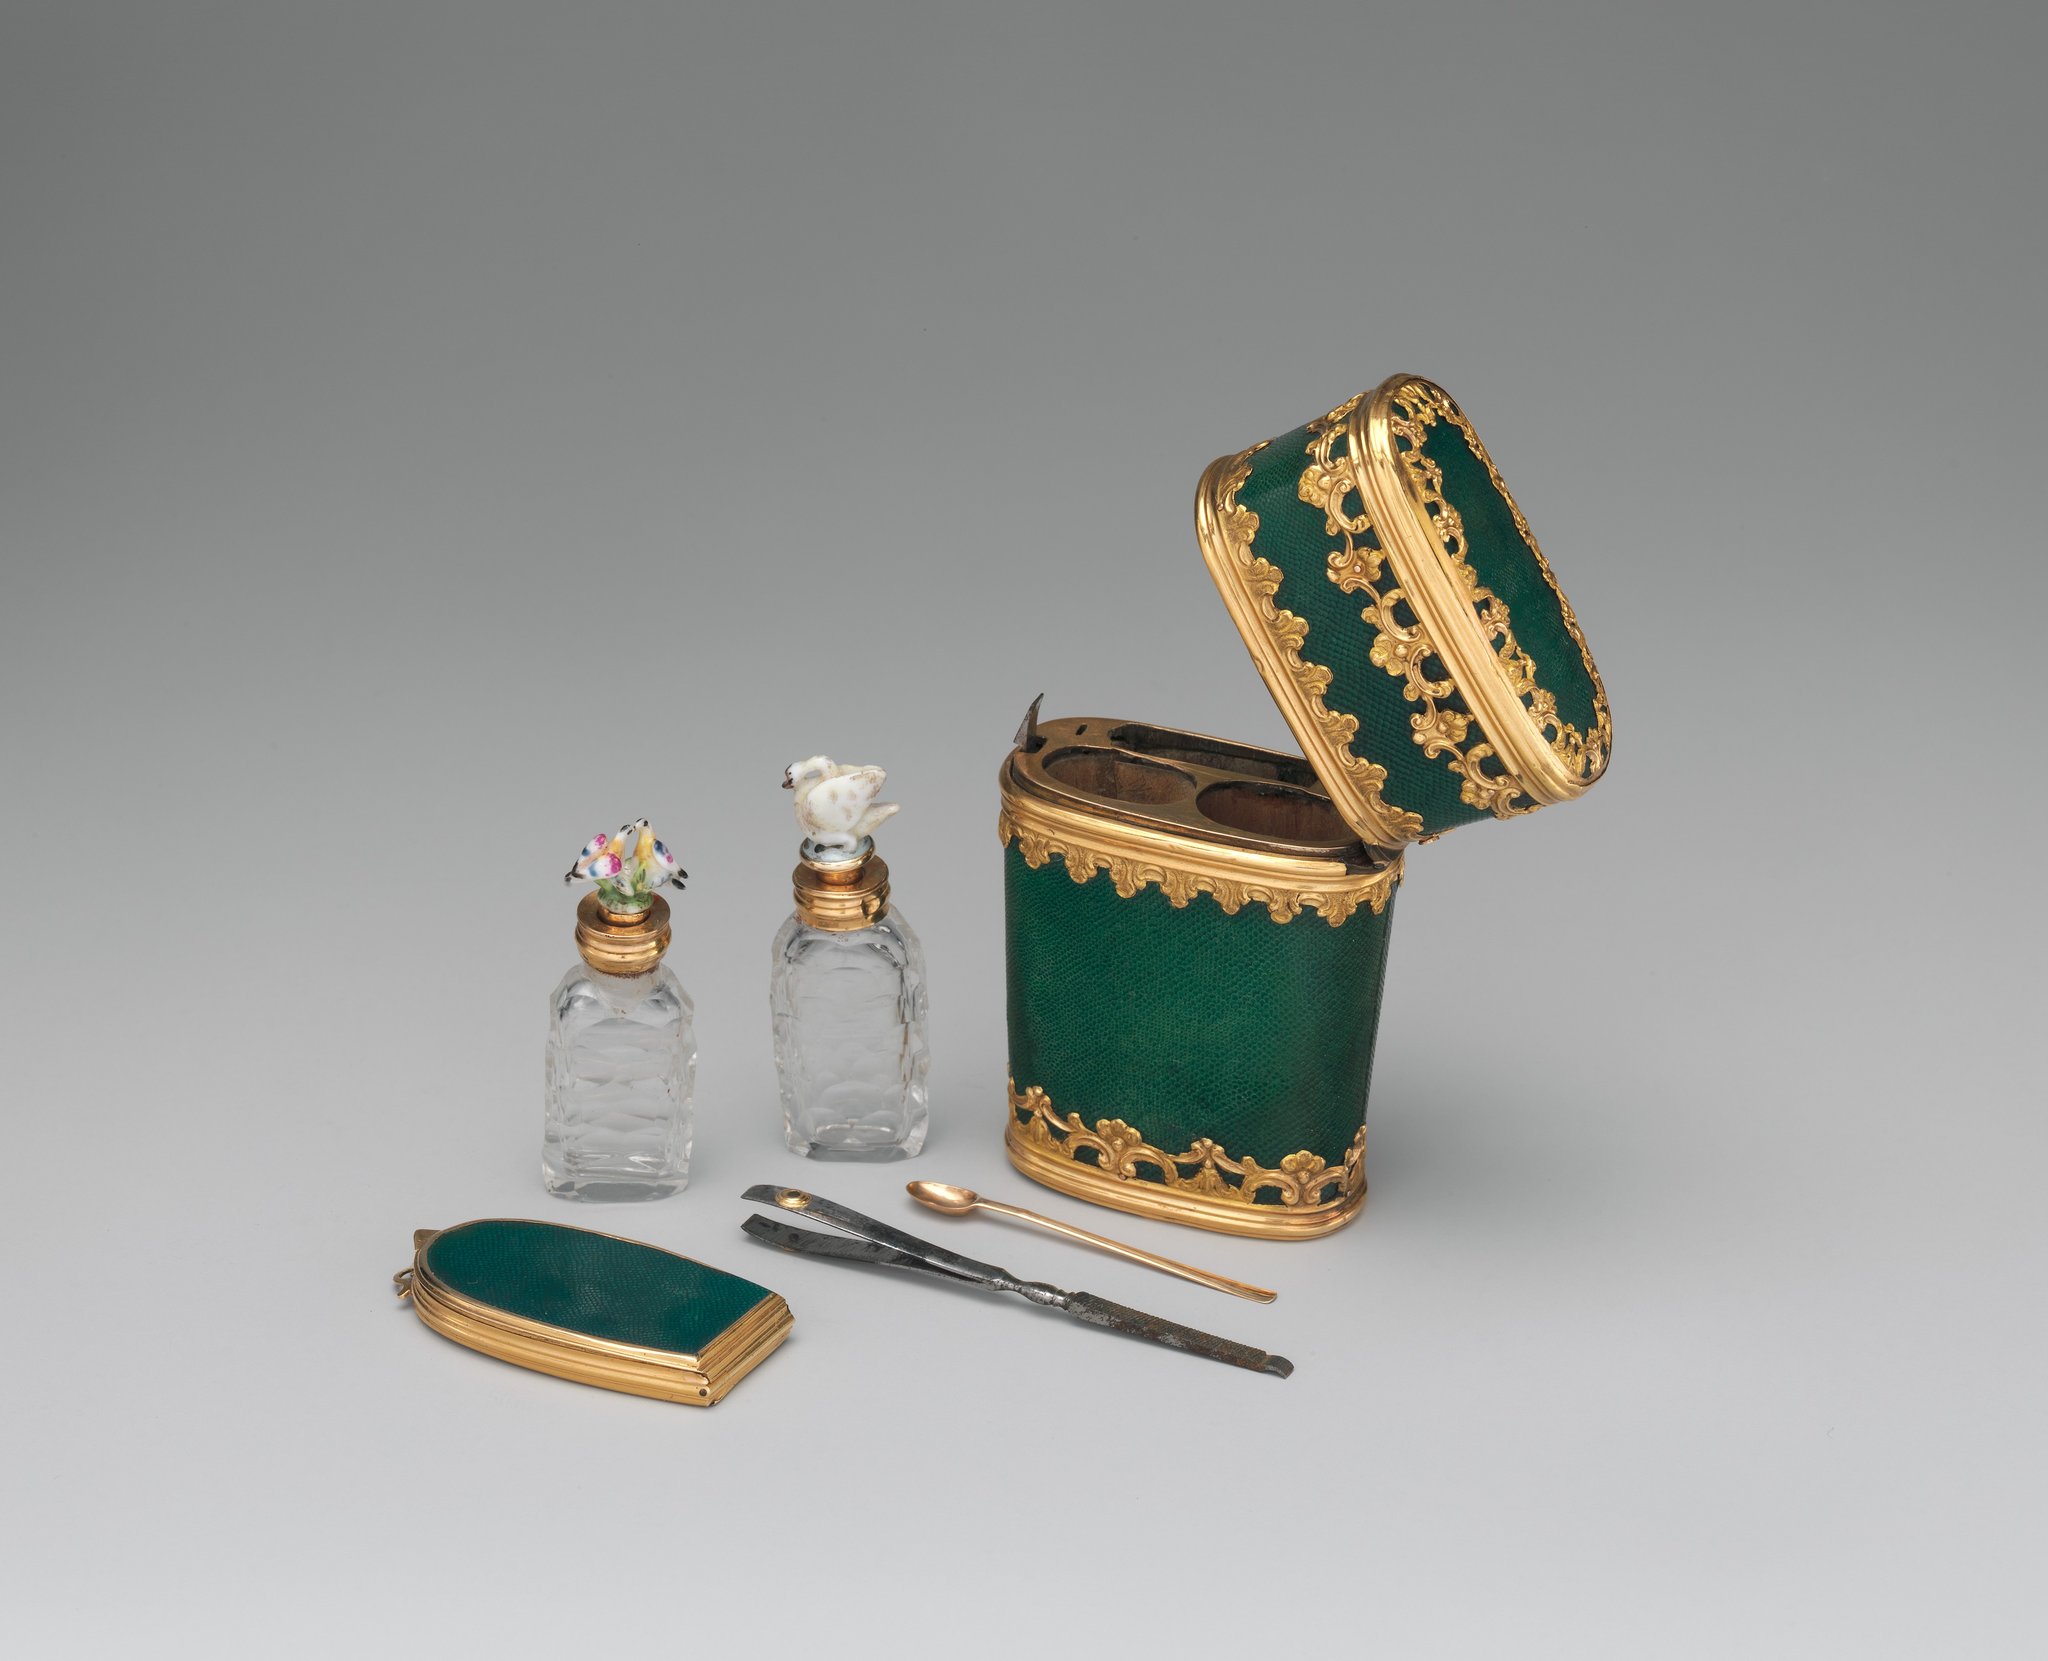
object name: nécessaire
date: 1751-1775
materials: glass, gold, porcelain, steel, wood